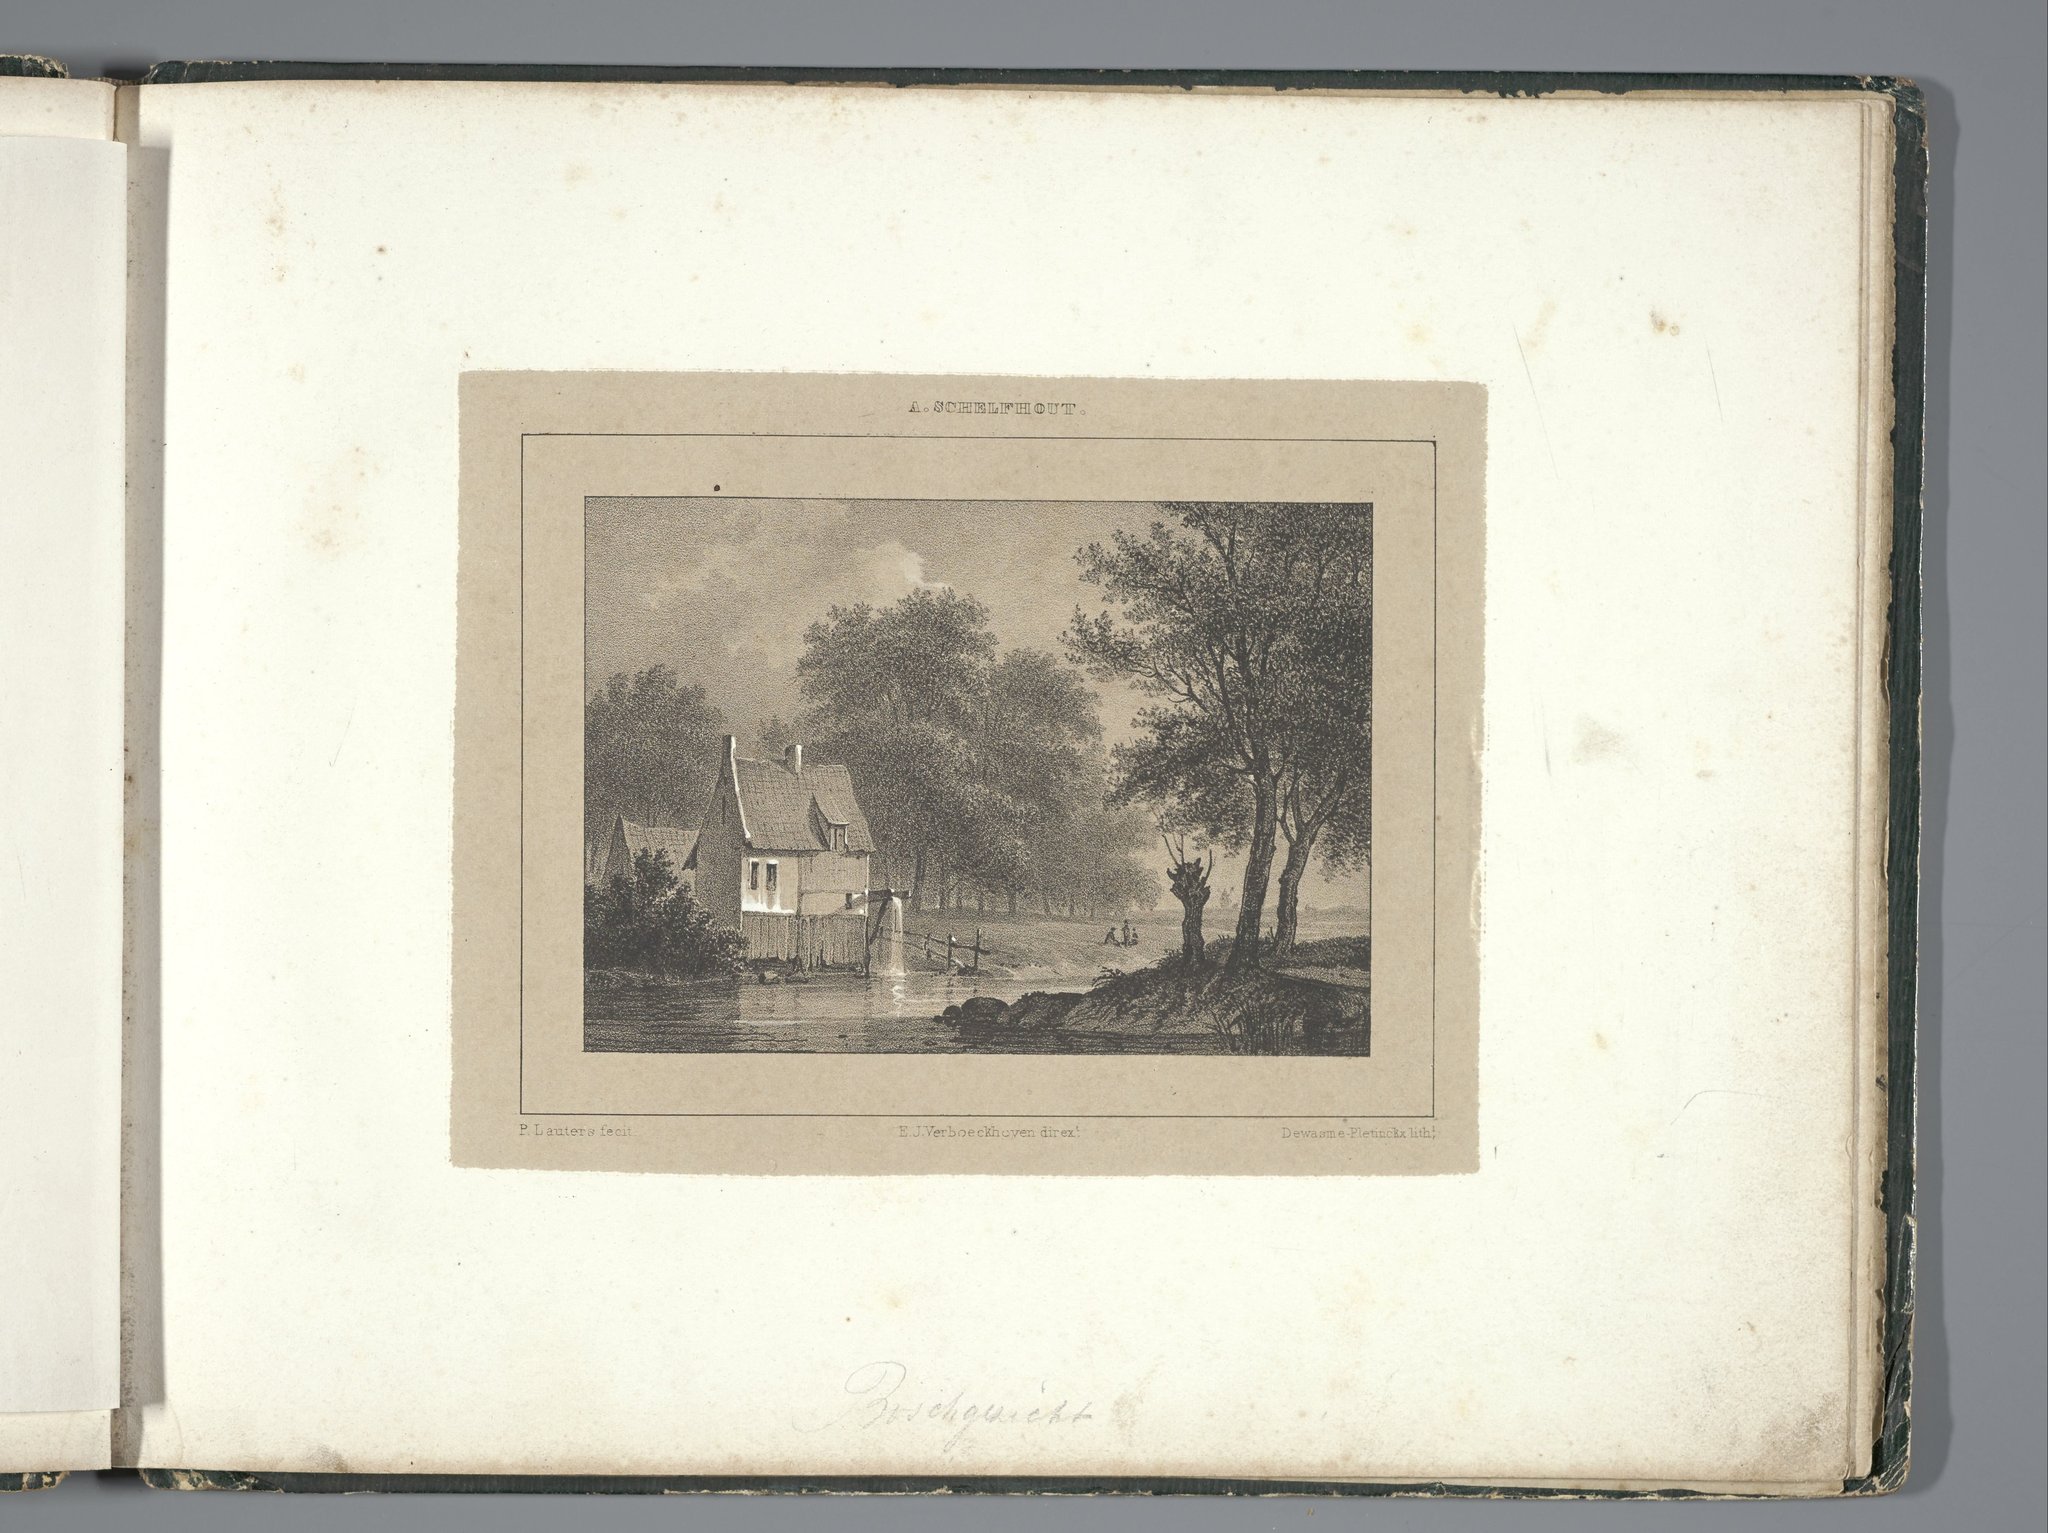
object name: print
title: Boschgezicht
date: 1830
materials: paper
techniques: lithograph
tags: city-view, and landscape with man-made constructions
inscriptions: inscription: ‘Boschgezicht’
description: Prent uit album met twaalf vroege lithografieën geproduceerd door de firma Dewasme-Pletinckx te Brussel naar J.C. Schotel, E.J. Verboeckhoven, B.J. van Hove en andere eigentijdse meesters in originele band.